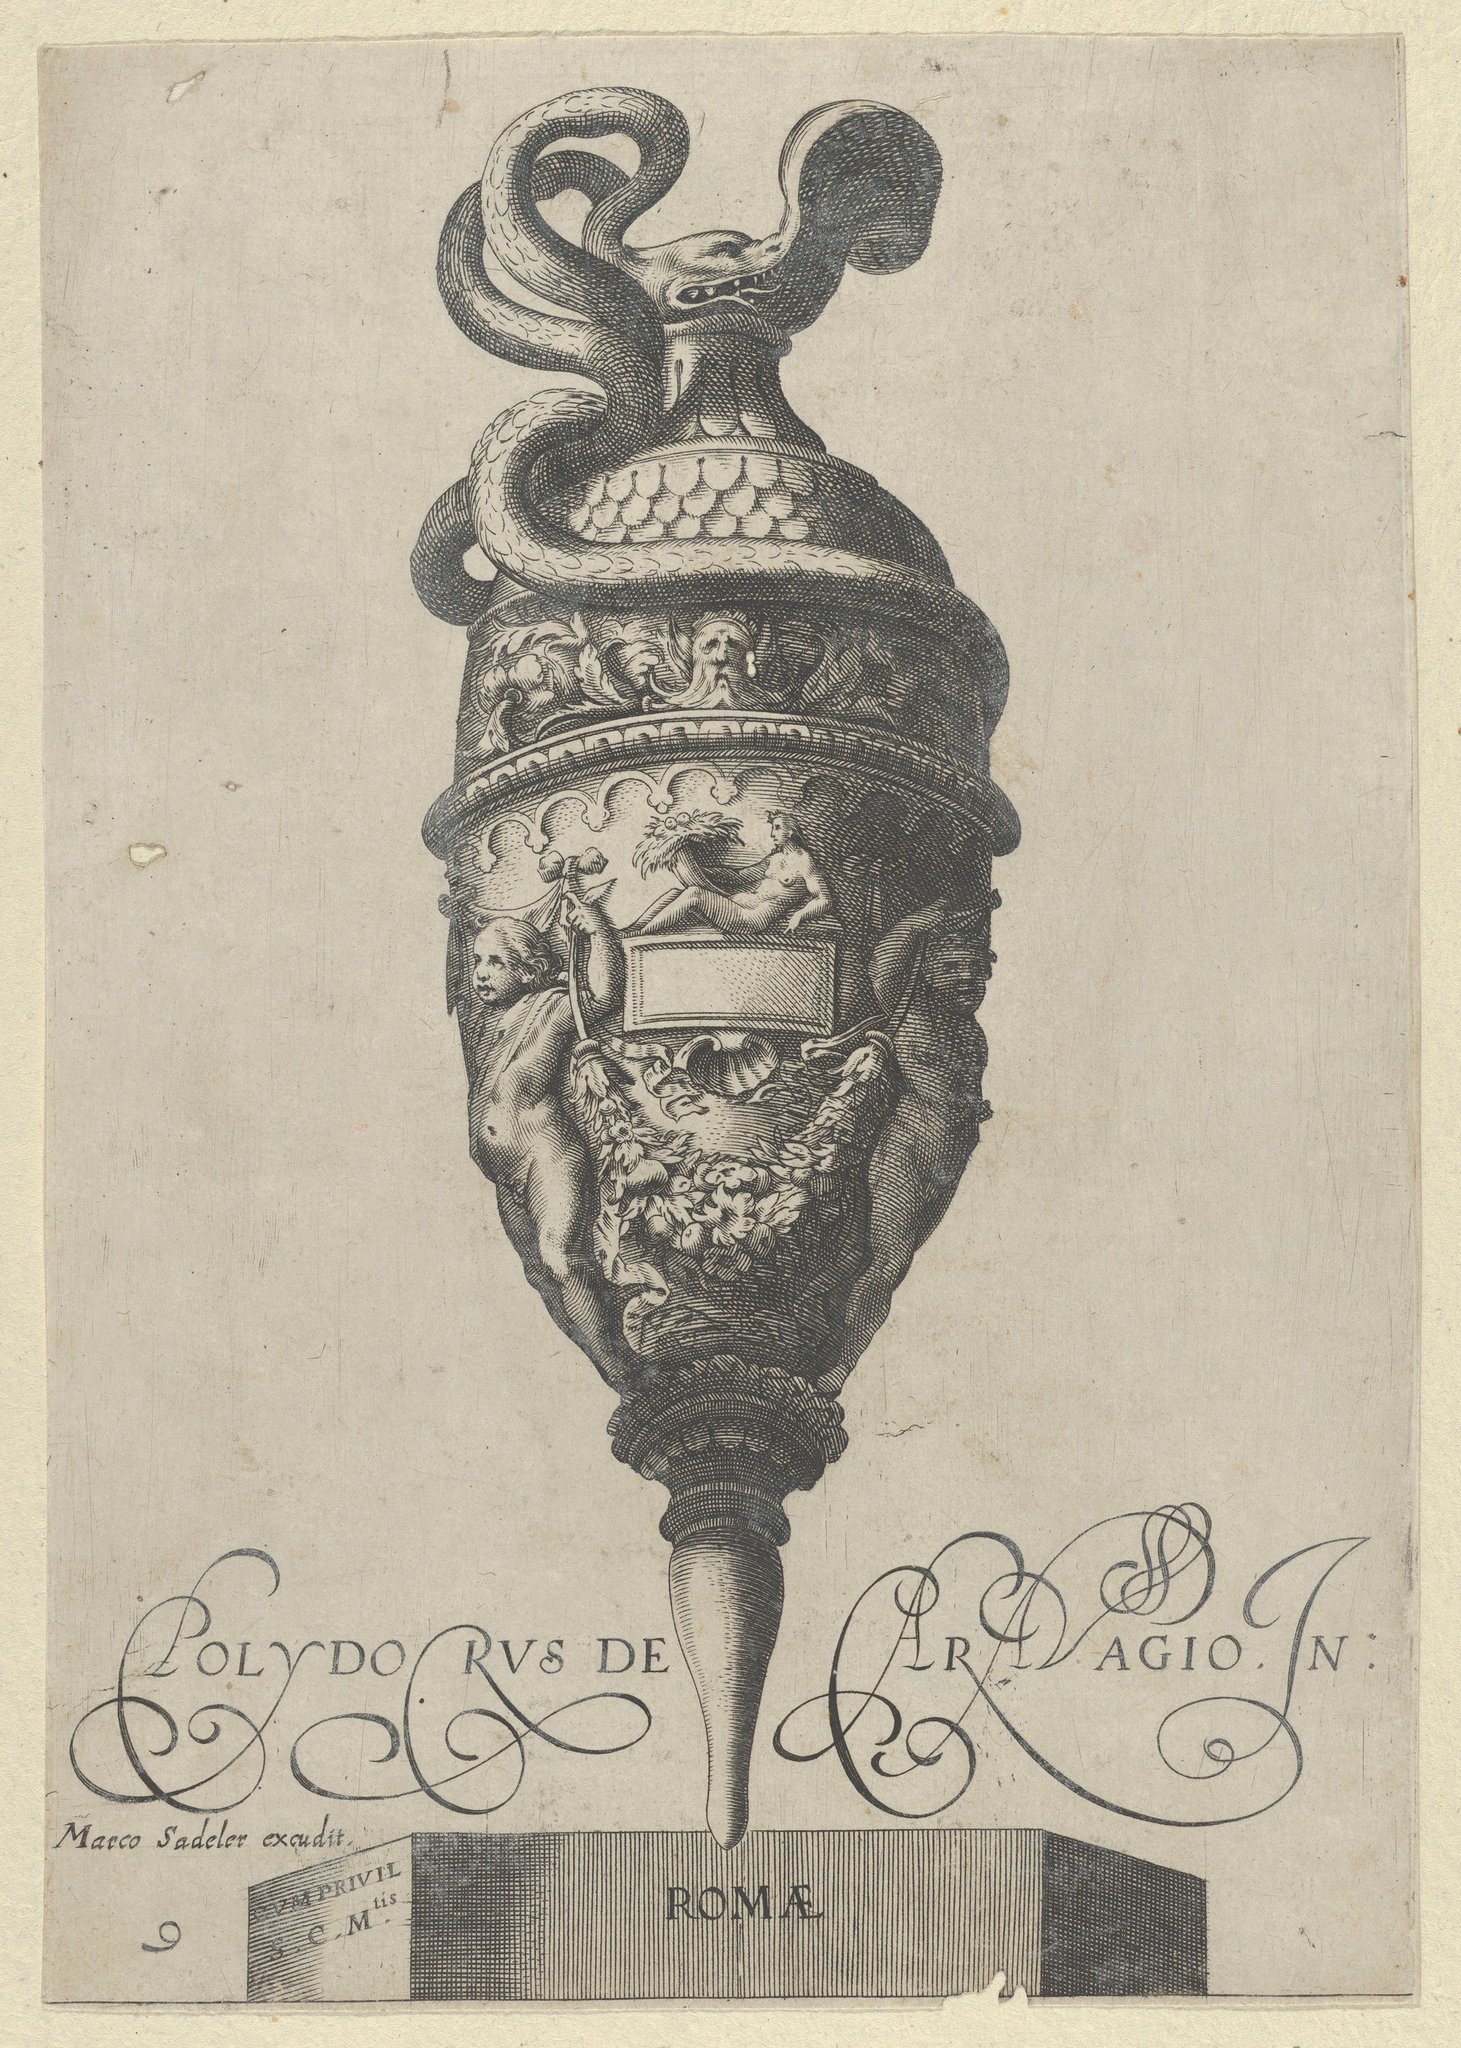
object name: print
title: Plate 9: Vase or Ewer with a Serpent Handle and Two Putti holding up a Garland, from "Antique Vases" (Vasa a Polydoro Caravagino)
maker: aegidius sadeler (ii)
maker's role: artist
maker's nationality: flemish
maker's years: 1568-1629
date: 1605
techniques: engraving, etching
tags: garlands,ornament,putti,serpents,vases